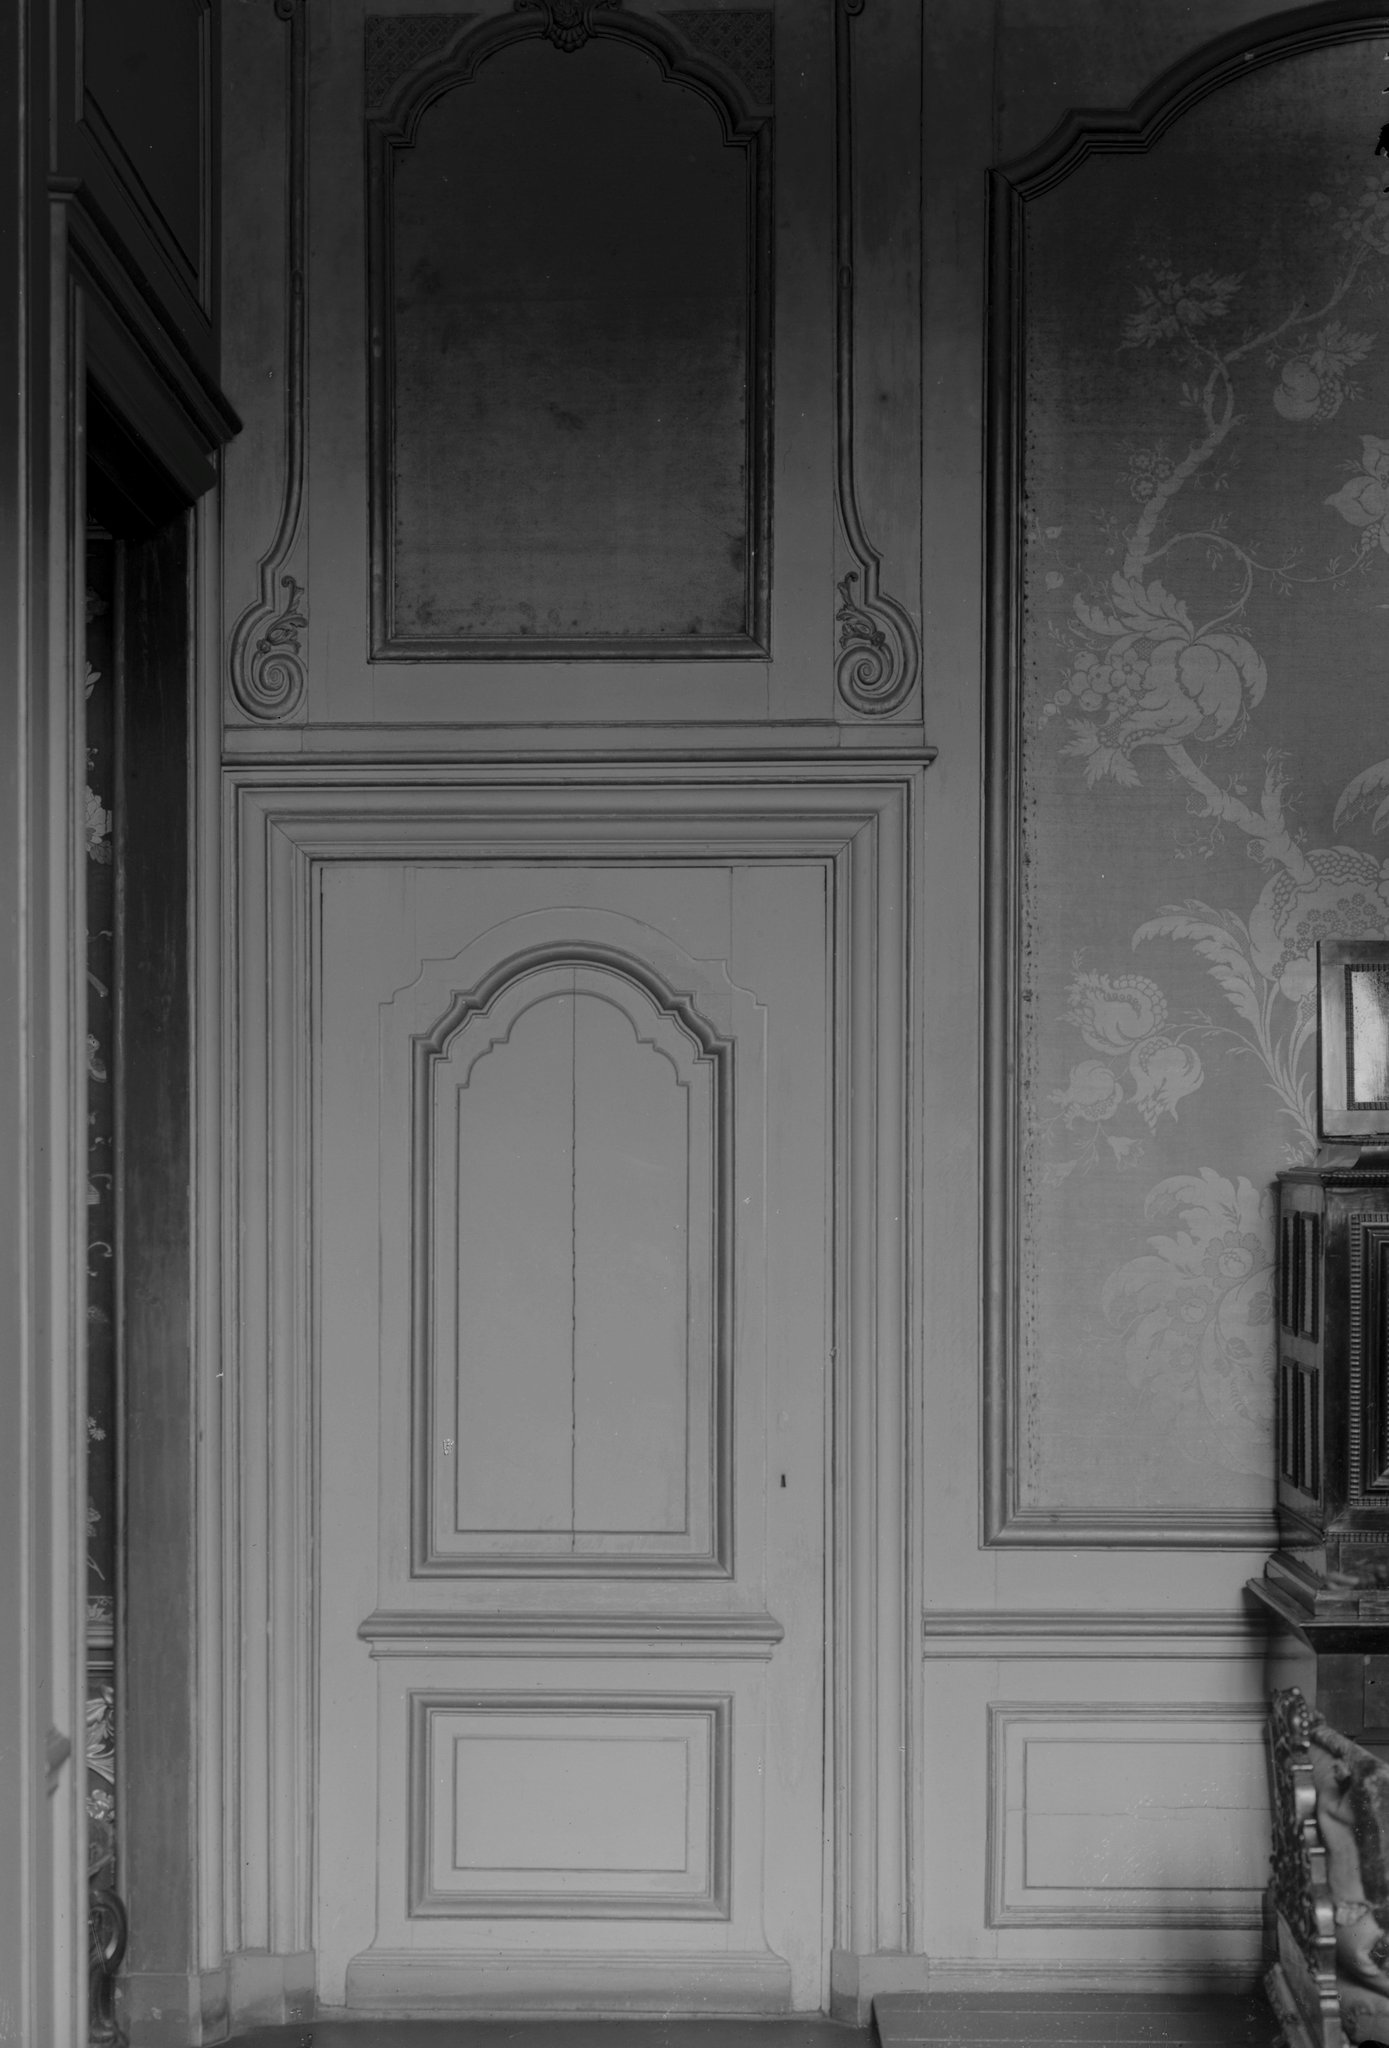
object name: overdoor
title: Delen betimmering afkomstig uit huis Constantijn Huygens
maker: Anonymous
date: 1700-1725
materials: marble, wood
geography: northern netherlands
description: Delen van een eikenhouten betimmering, groenblauw geschilderd en met goud afgezet, bestaande uit een schoorsteen, drie wandvakken, twee deuren met dessus de porte, delen van de raamwand en blinden voor drie ramen. De schoorsteenmantel is van roodgrijs geaderd marmer. Afkomstig uit het huis van Constantijn Huygens op het Plein te 's-Gravenhage. Verschillende delen zijn ter aanvulling bijgemaakt.